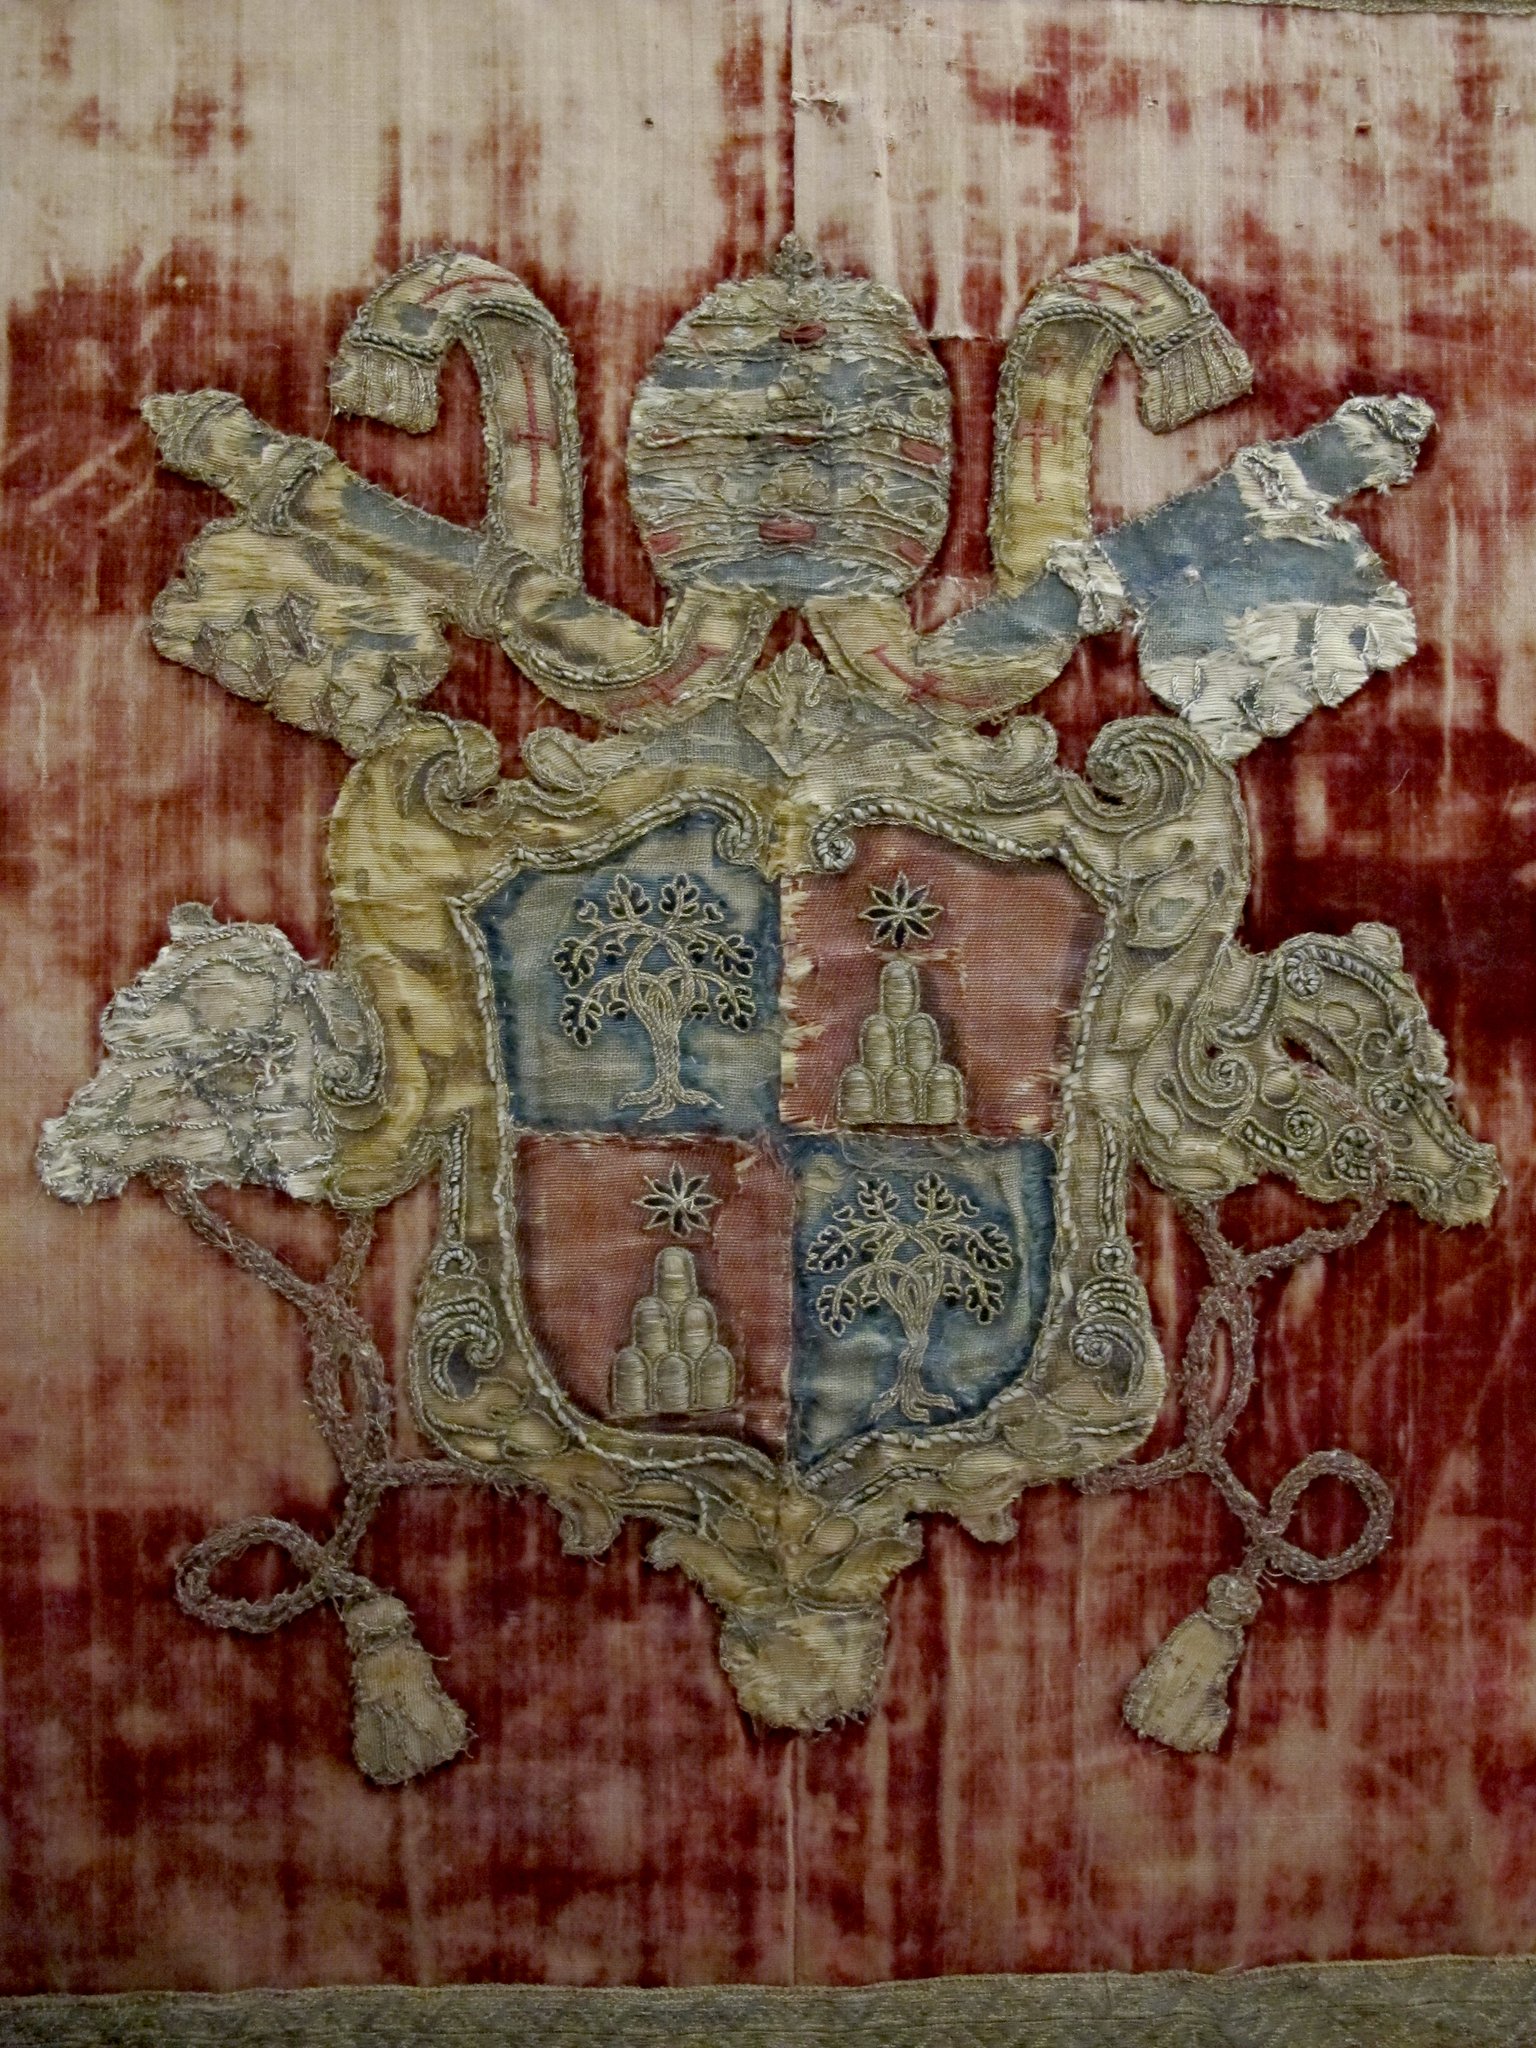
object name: valance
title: Valance with Chigi coat of arms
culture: italian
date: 1634-1666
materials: cotton, gilt, linen, silk, velvet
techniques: cutting, weave